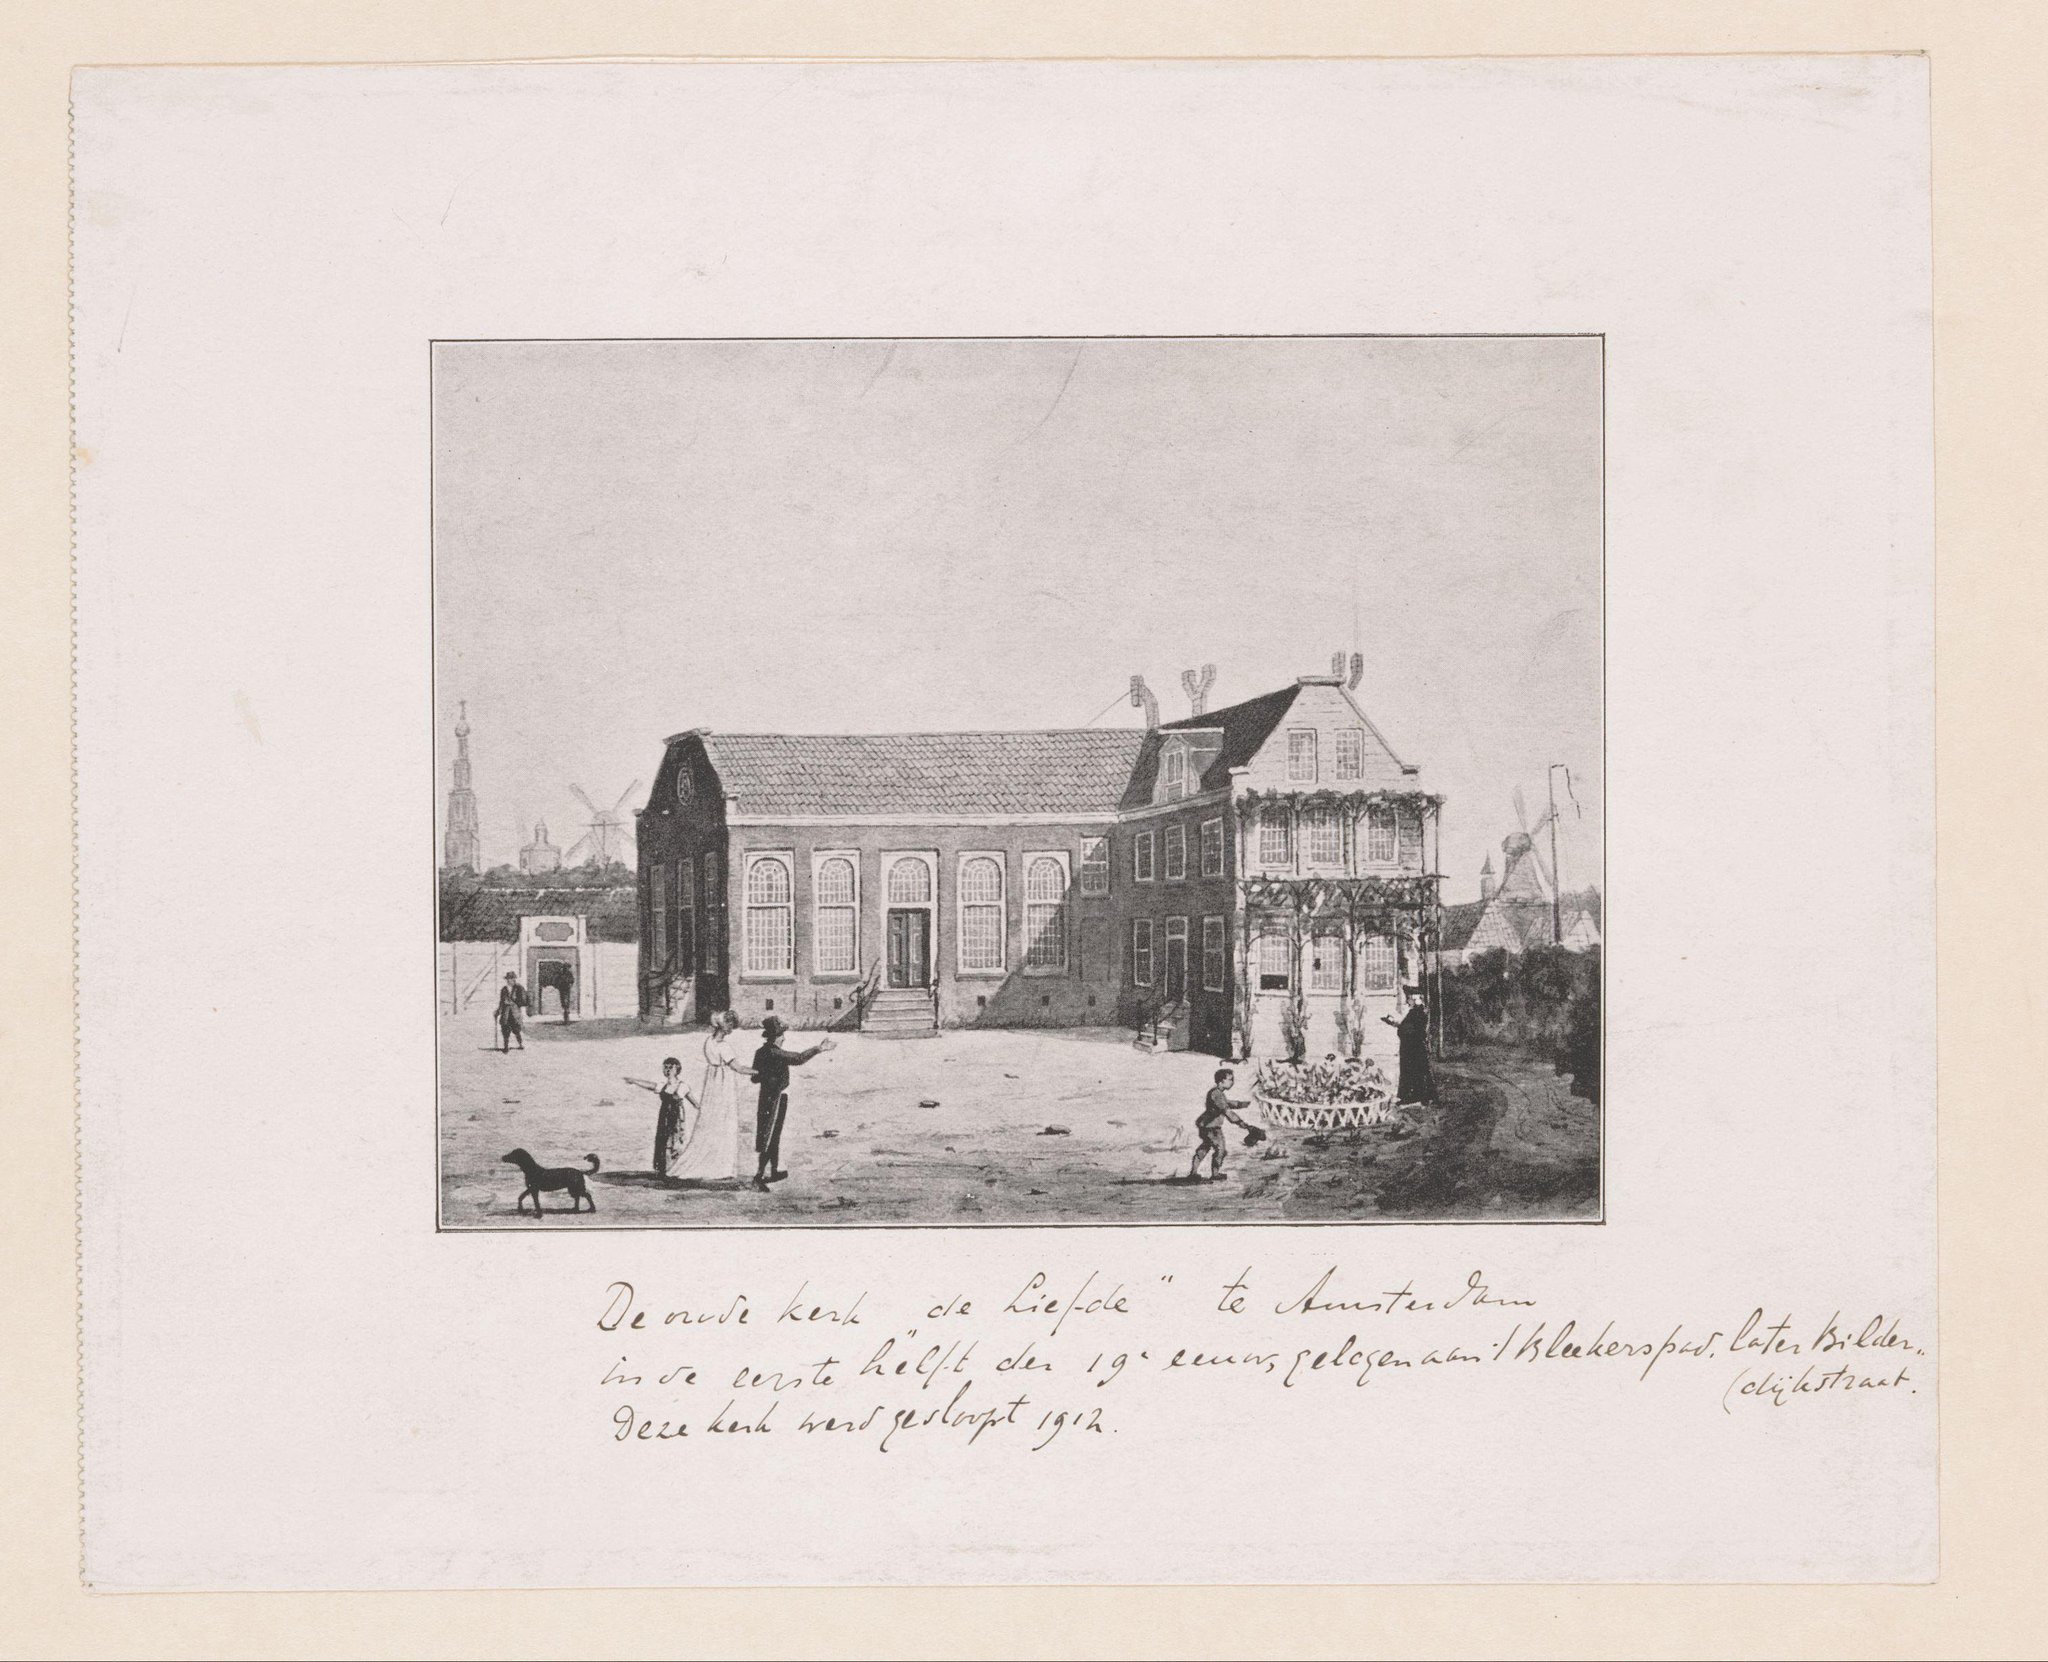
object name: reproduction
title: Reproductie van een prent van een gezicht op de oude kerk De Liefde te Amsterdam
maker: Anonymous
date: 1890-1912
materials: cardboard, paper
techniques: autotype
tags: church (exterior), street (+ city(-scape) with figures, staffage), amsterdam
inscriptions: annotation: ‘nummer correspondeert niet met prent inventaris’, collector's mark: Lugt 2228, number: ‘'12 166’